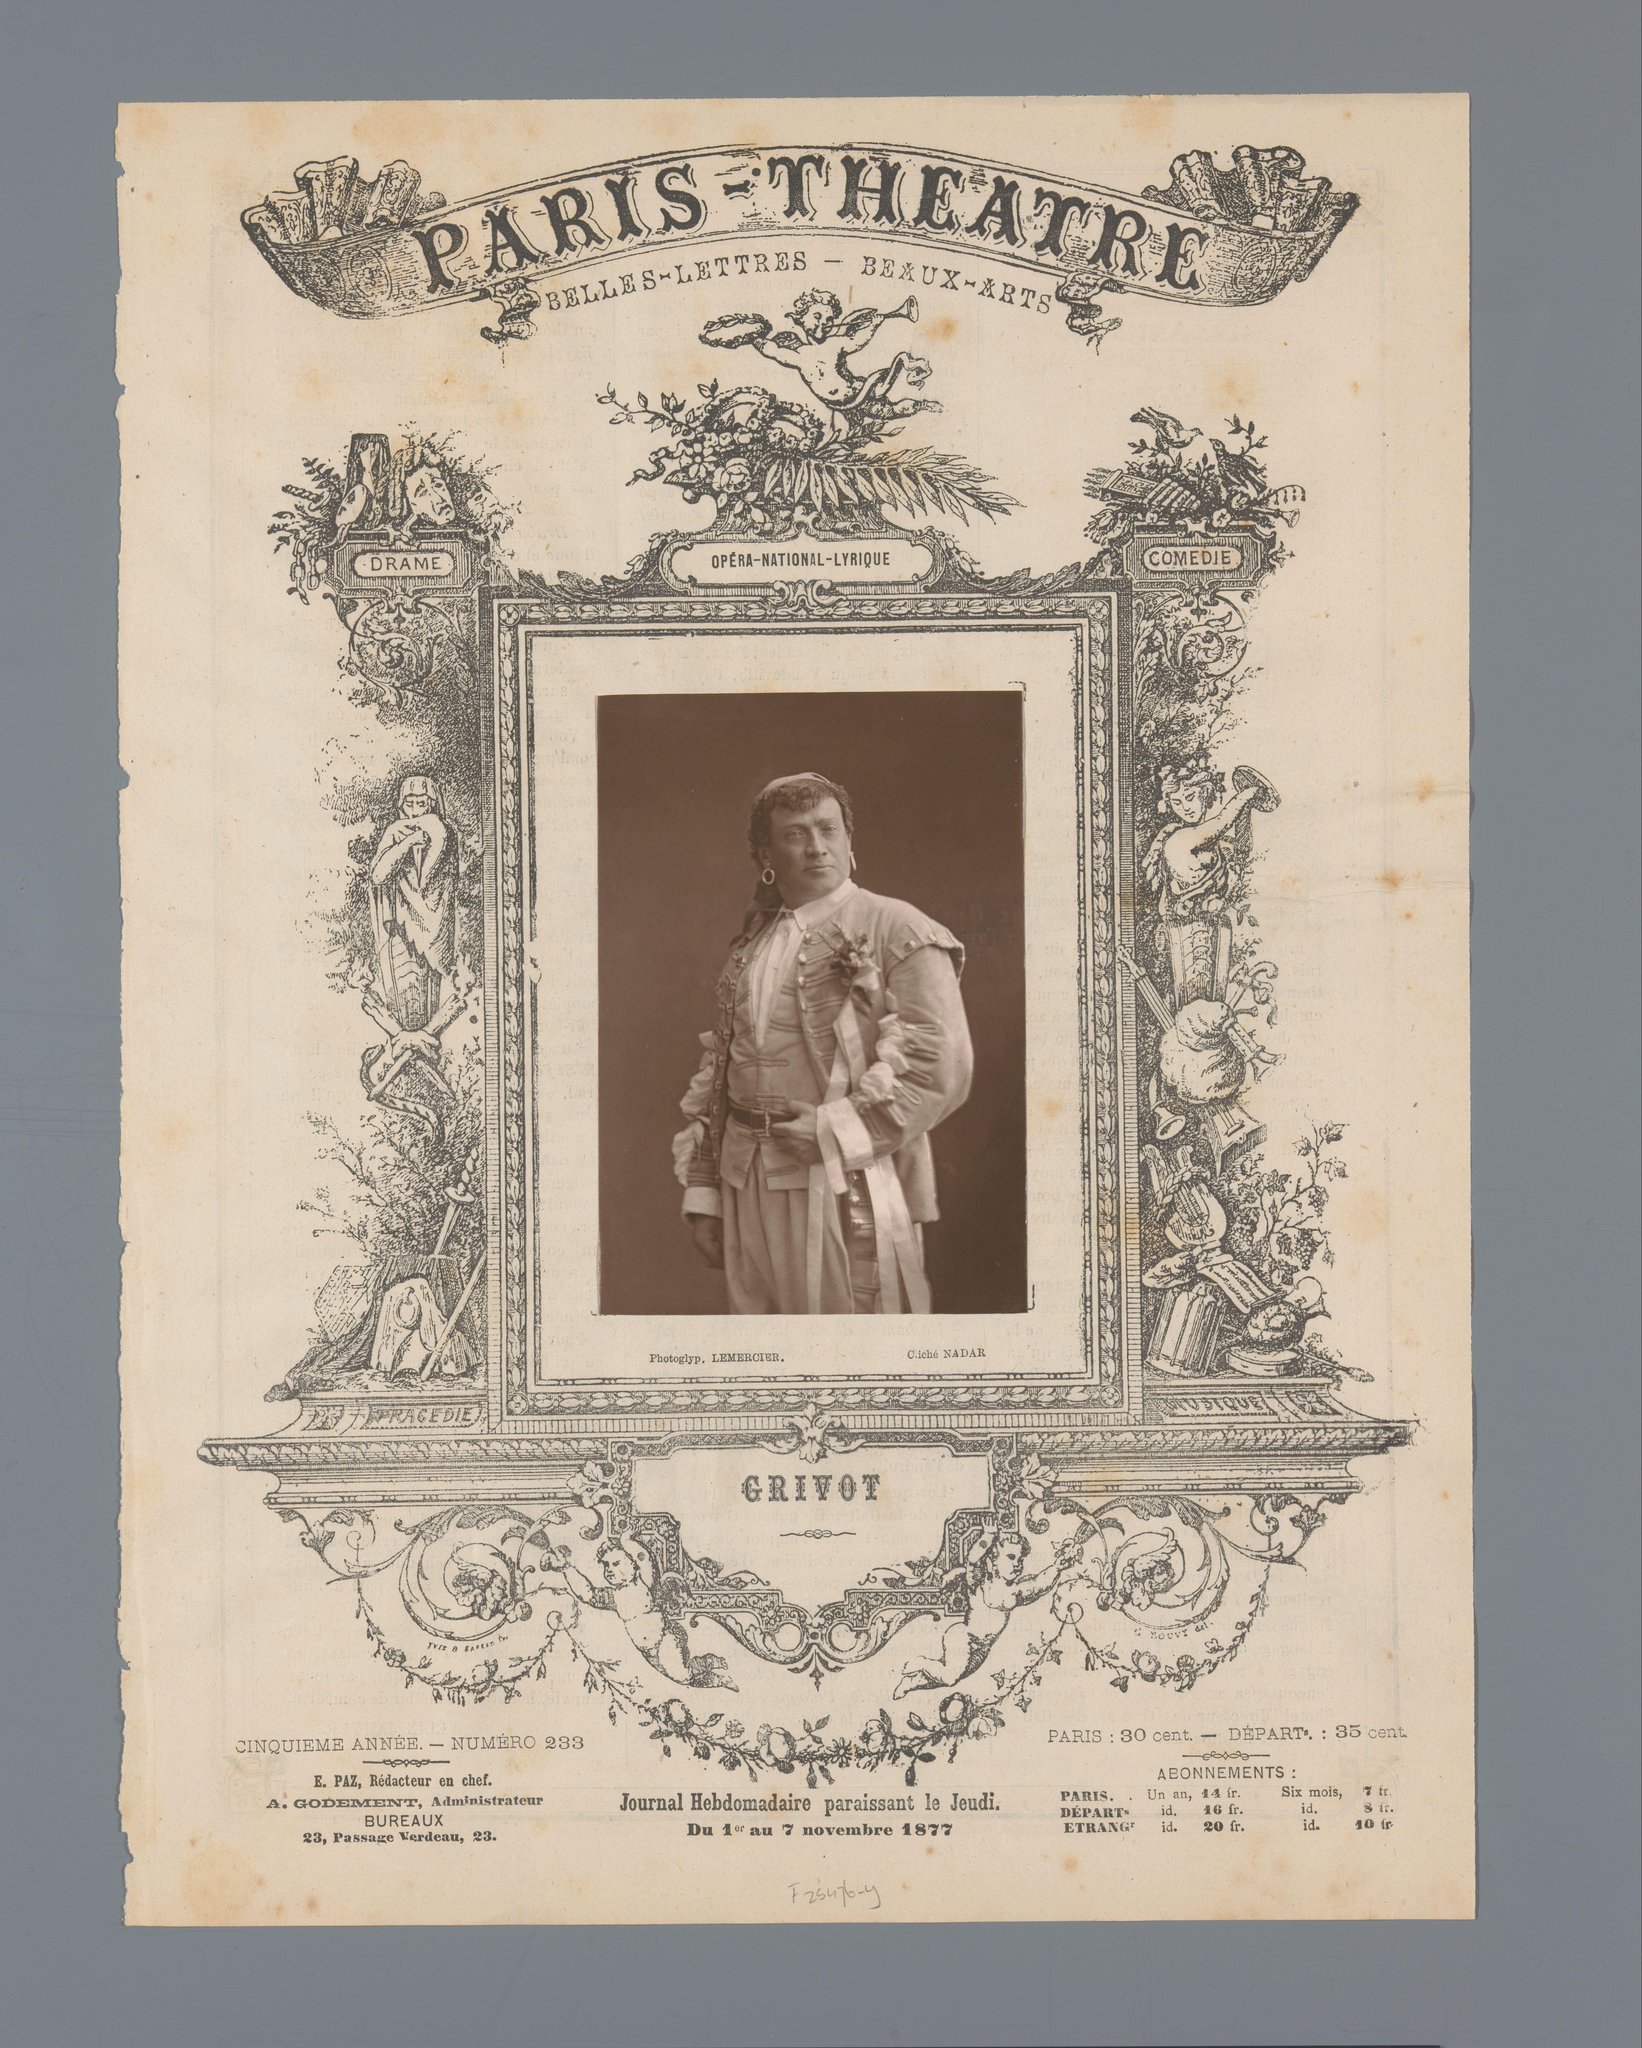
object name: photomechanical print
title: Portret van Pierre Grivot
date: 1872-1879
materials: paper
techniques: woodburytype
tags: historical persons